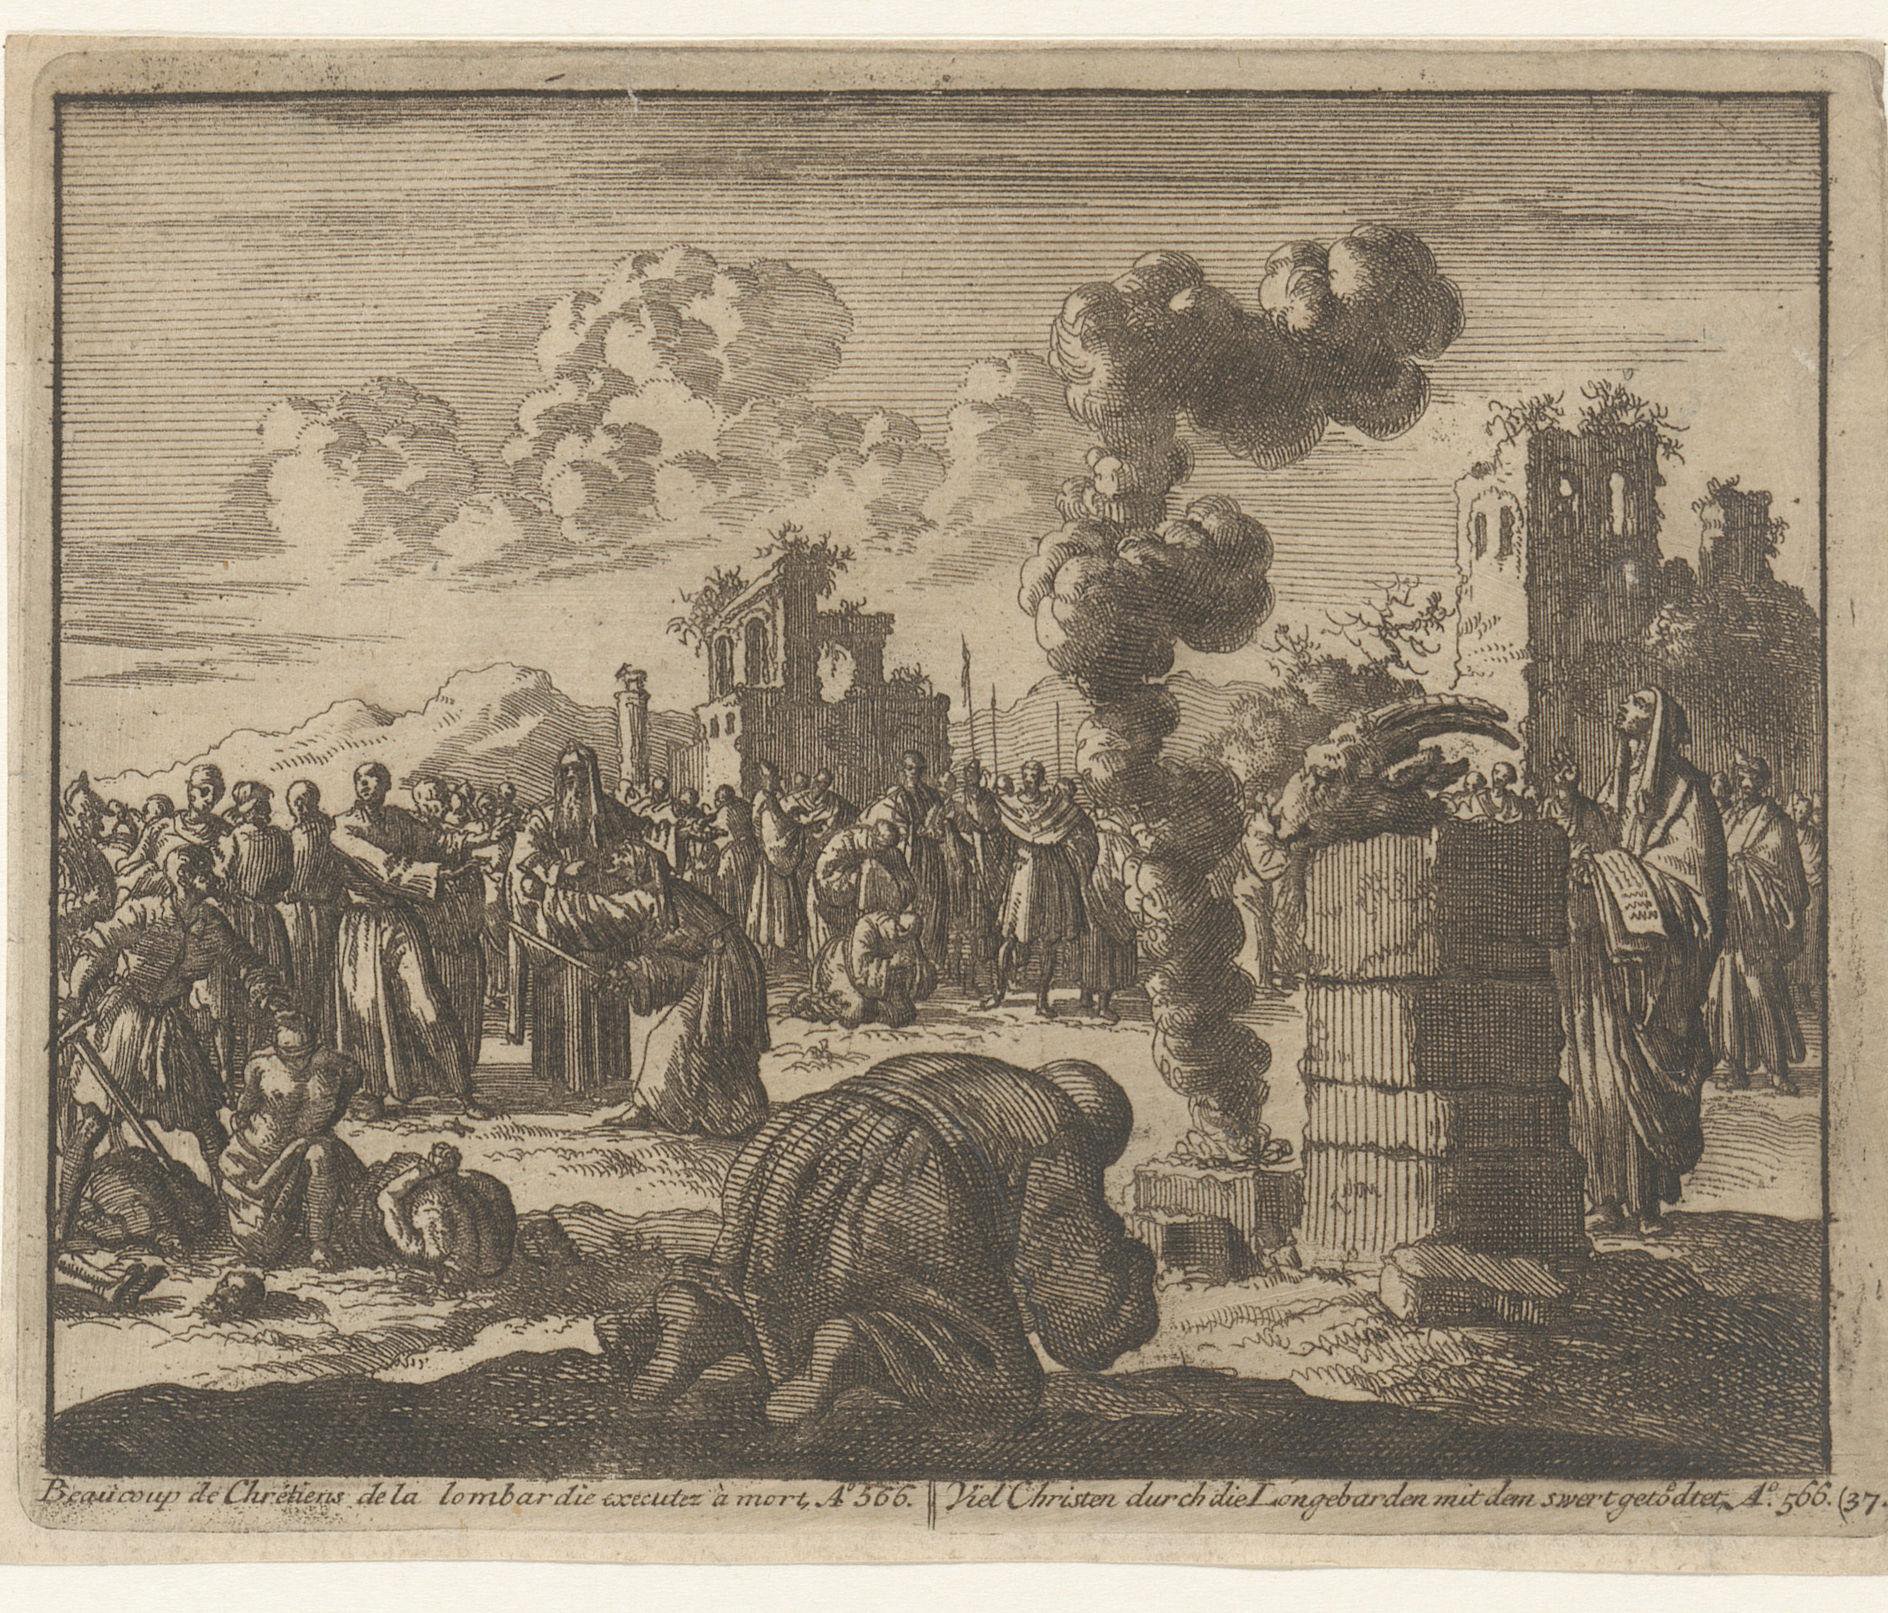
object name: print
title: Christenen door Longobarden gedood omdat ze weigeren mee te werken aan het offeren van een geitenbok, in het jaar 566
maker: jan luyken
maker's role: draughtsman, print maker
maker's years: 1649-1712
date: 1685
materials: paper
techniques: etching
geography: amsterdam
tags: extinct, 'historical' peoples (lombards), violent death, being killed; being mishandled and maltreated; seeking death, animal sacrifice ~ non-christian religions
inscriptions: collector's mark: Lugt 2228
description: Christenen door Longobarden gedood omdat ze weigeren mee te werken aan het offeren van een geitenbok, in het jaar 566. Met onderschriften in het Duits en Frans. Rechtsonder genummerd: 37.